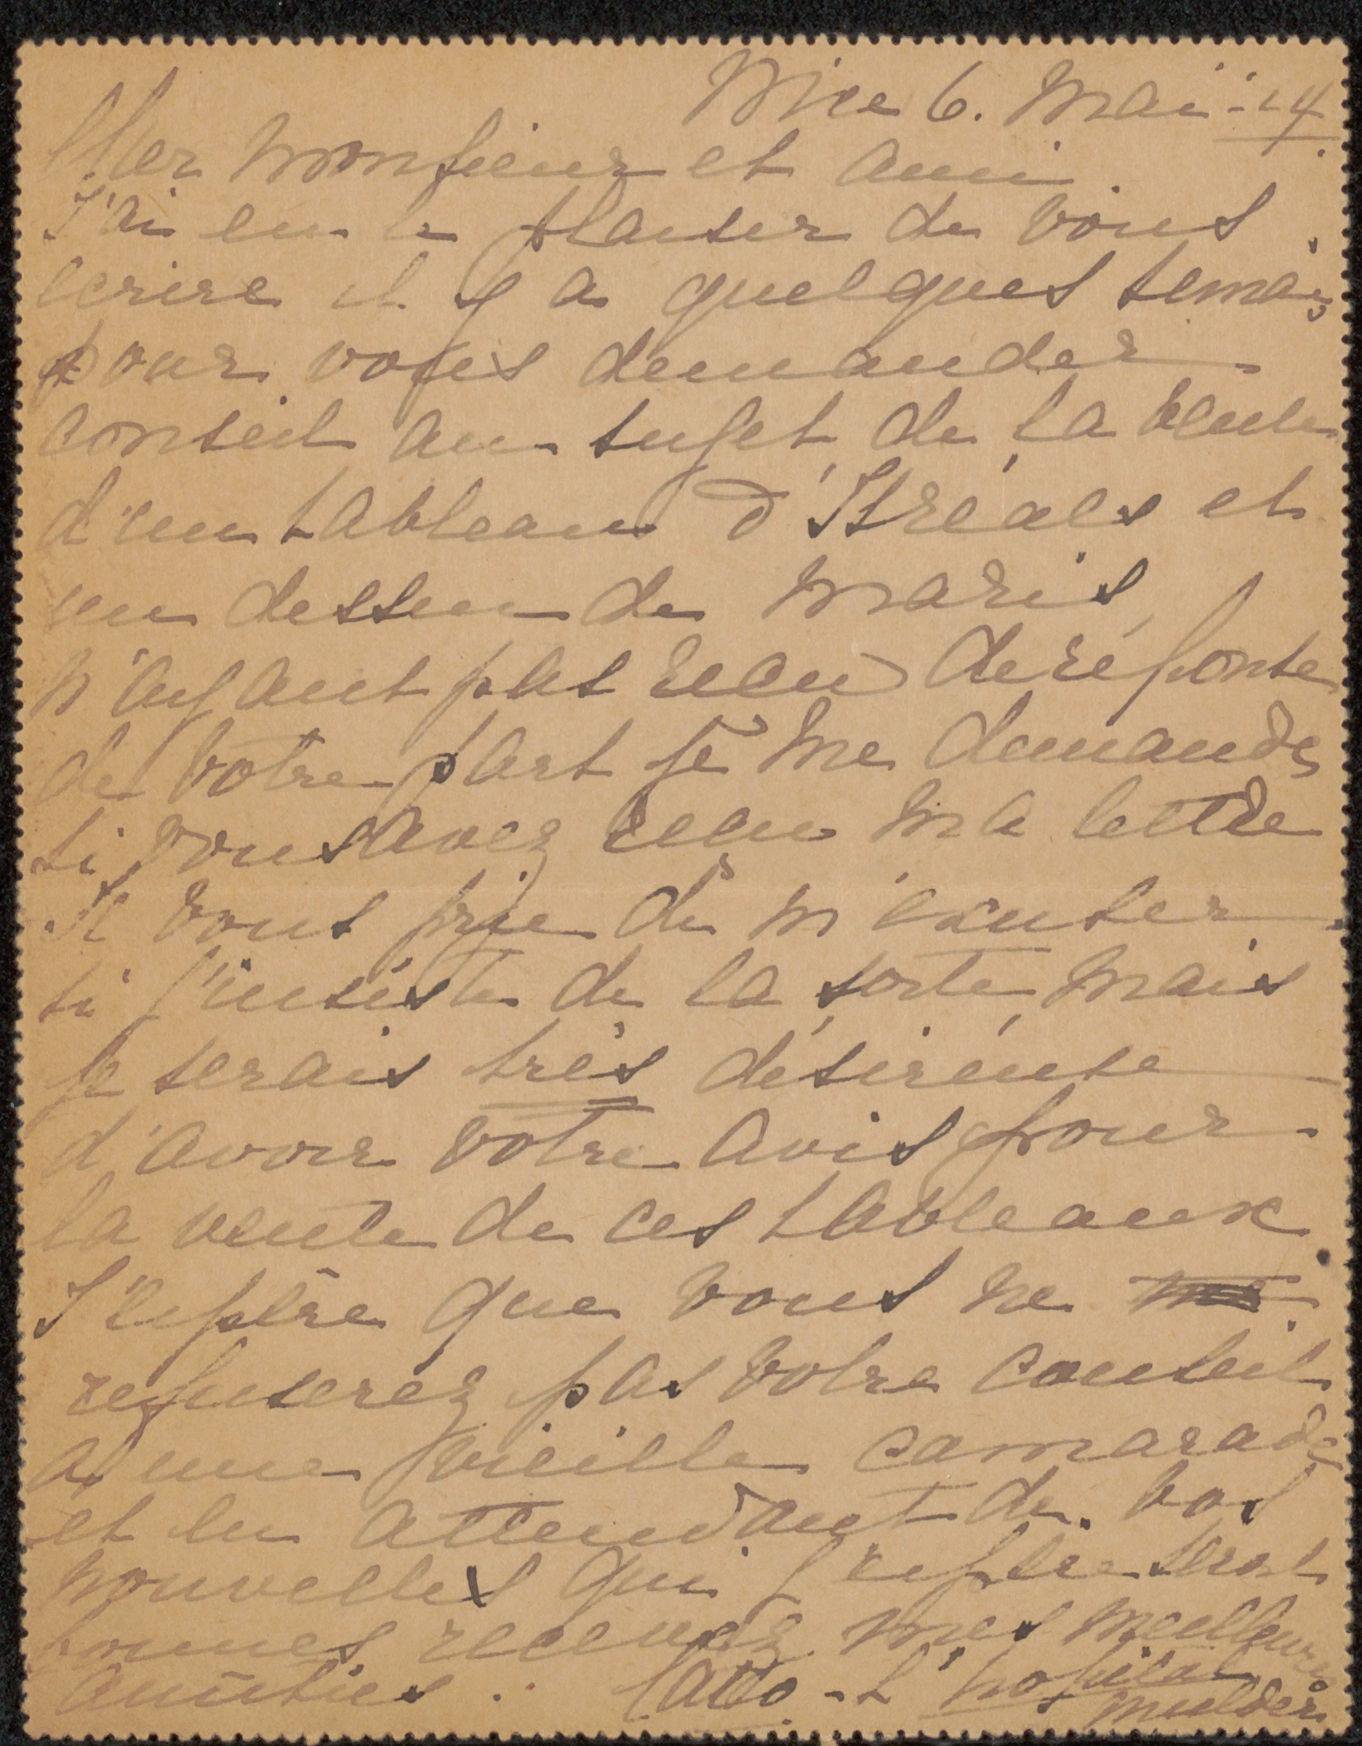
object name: postcard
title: Briefkaart aan Philip Zilcken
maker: cato l hôpital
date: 1914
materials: ink, paper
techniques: pen, writing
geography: nice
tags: the hague, painter, philip zilcken, drawing, painting (including book-illumination, miniature-painting)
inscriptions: collector's mark: ‘RPK’